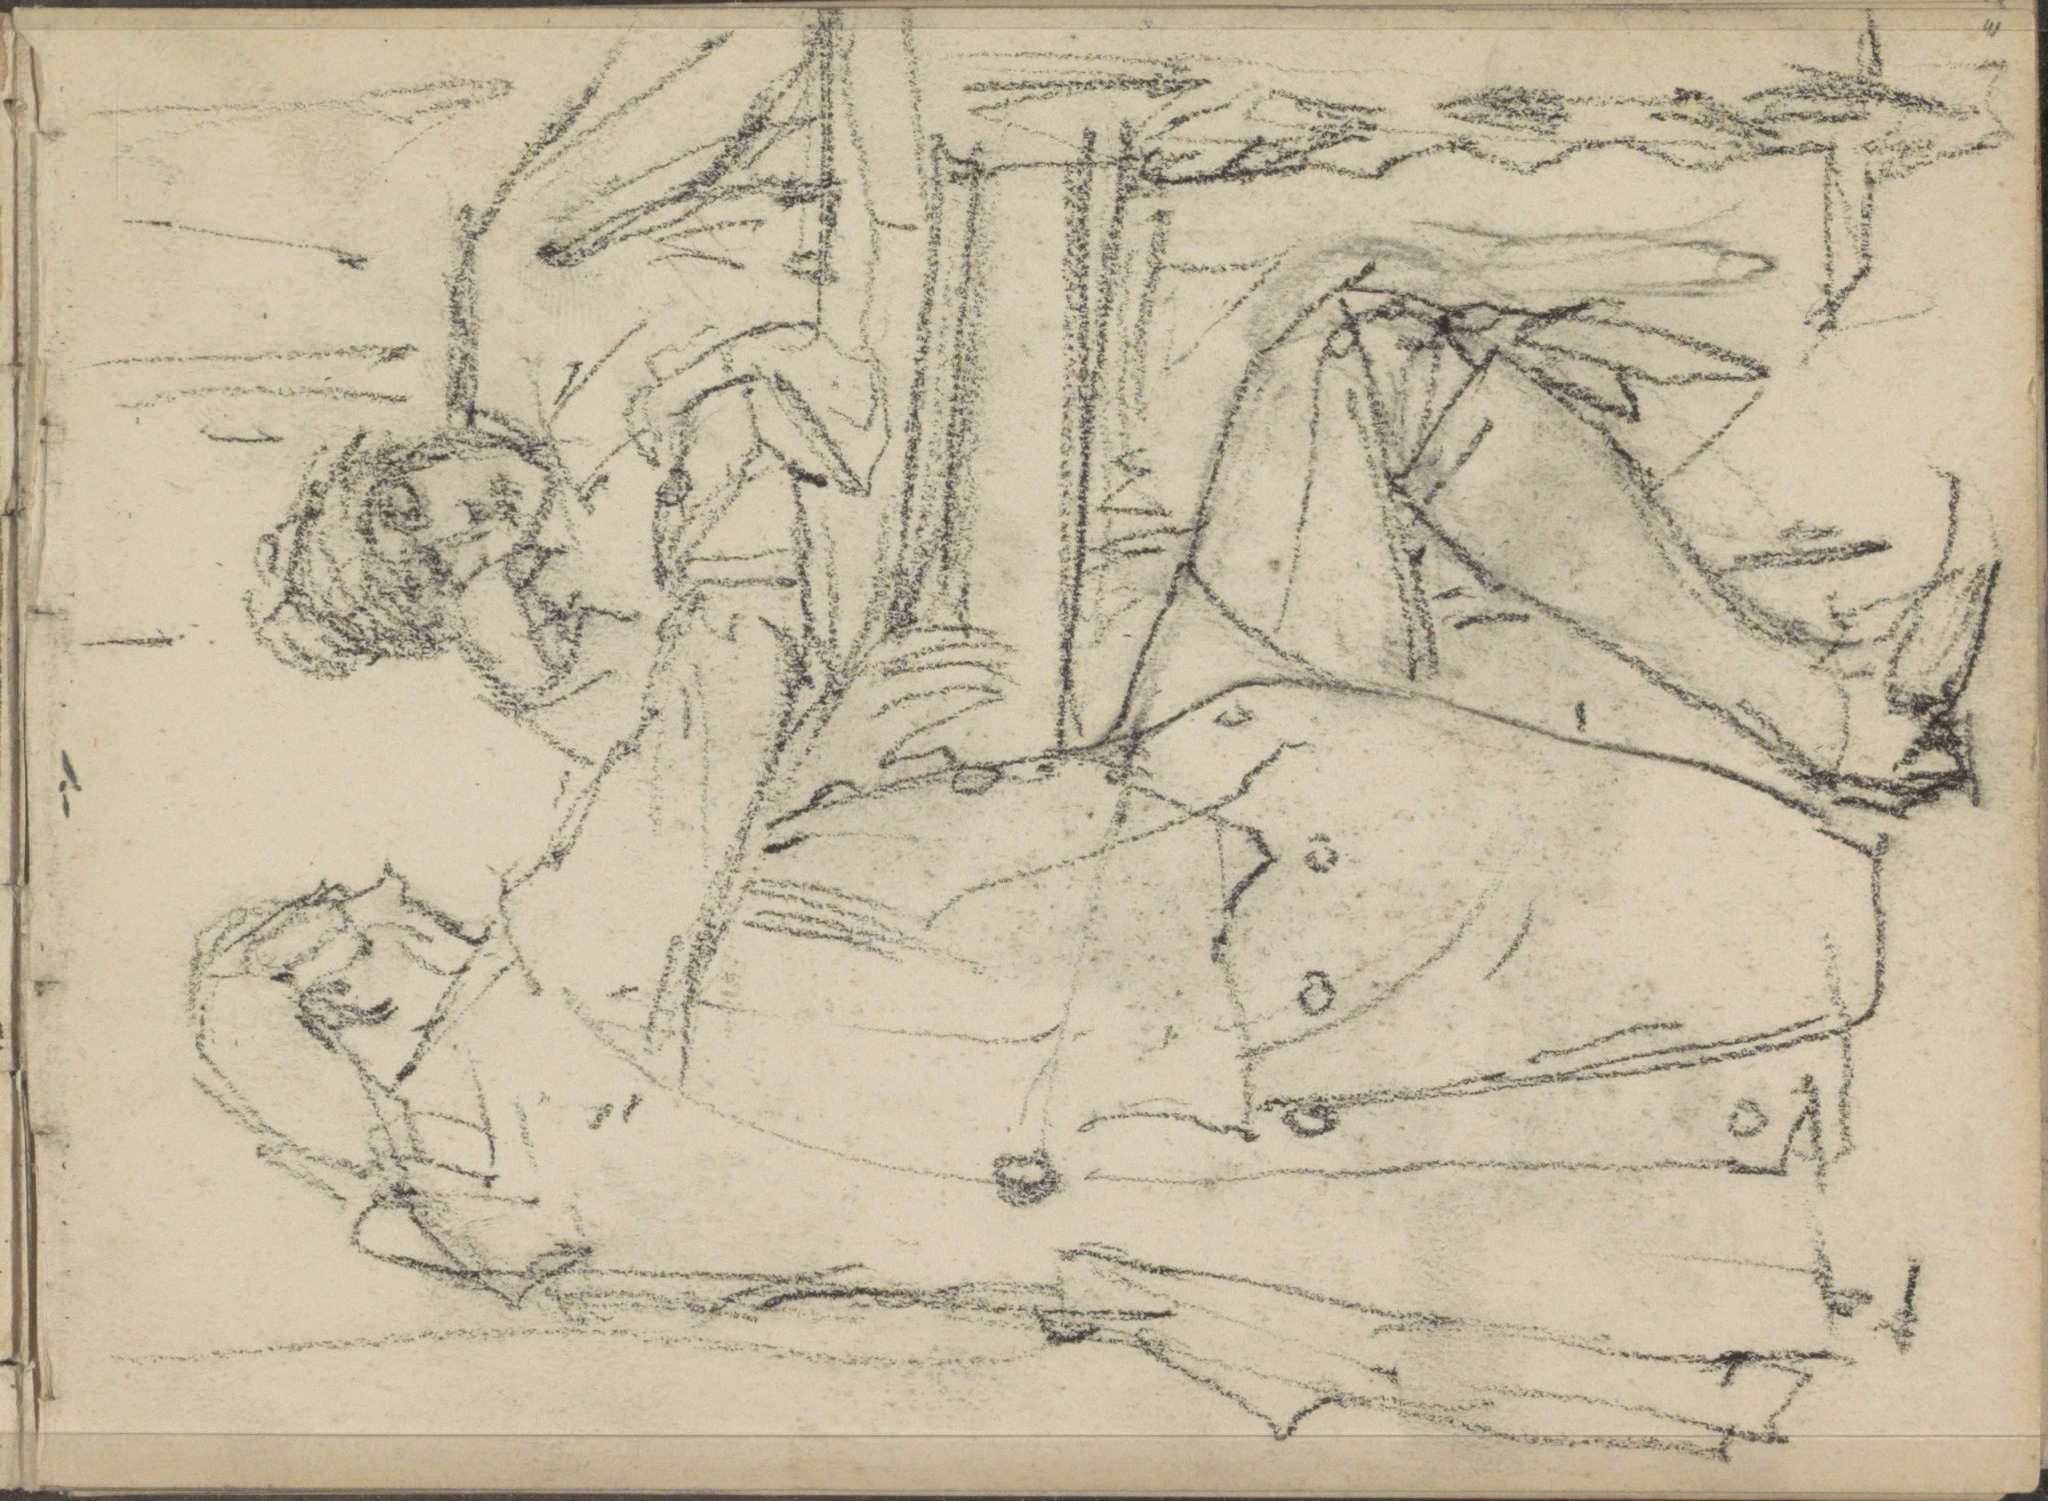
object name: sketchbook leaf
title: Man en vrouw aan een tafel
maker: marius bauer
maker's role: draughtsman, print maker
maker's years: 1867-1932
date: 1879-1884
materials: chalk, paper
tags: sitting figure, adult woman, adult man, table, historical costume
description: De man draagt achttiende-eeuws kostuum. De vrouw leunt op de tafel met haar hoofd in haar hand. Pagina 41 uit een schetsboek met 28 bladen.